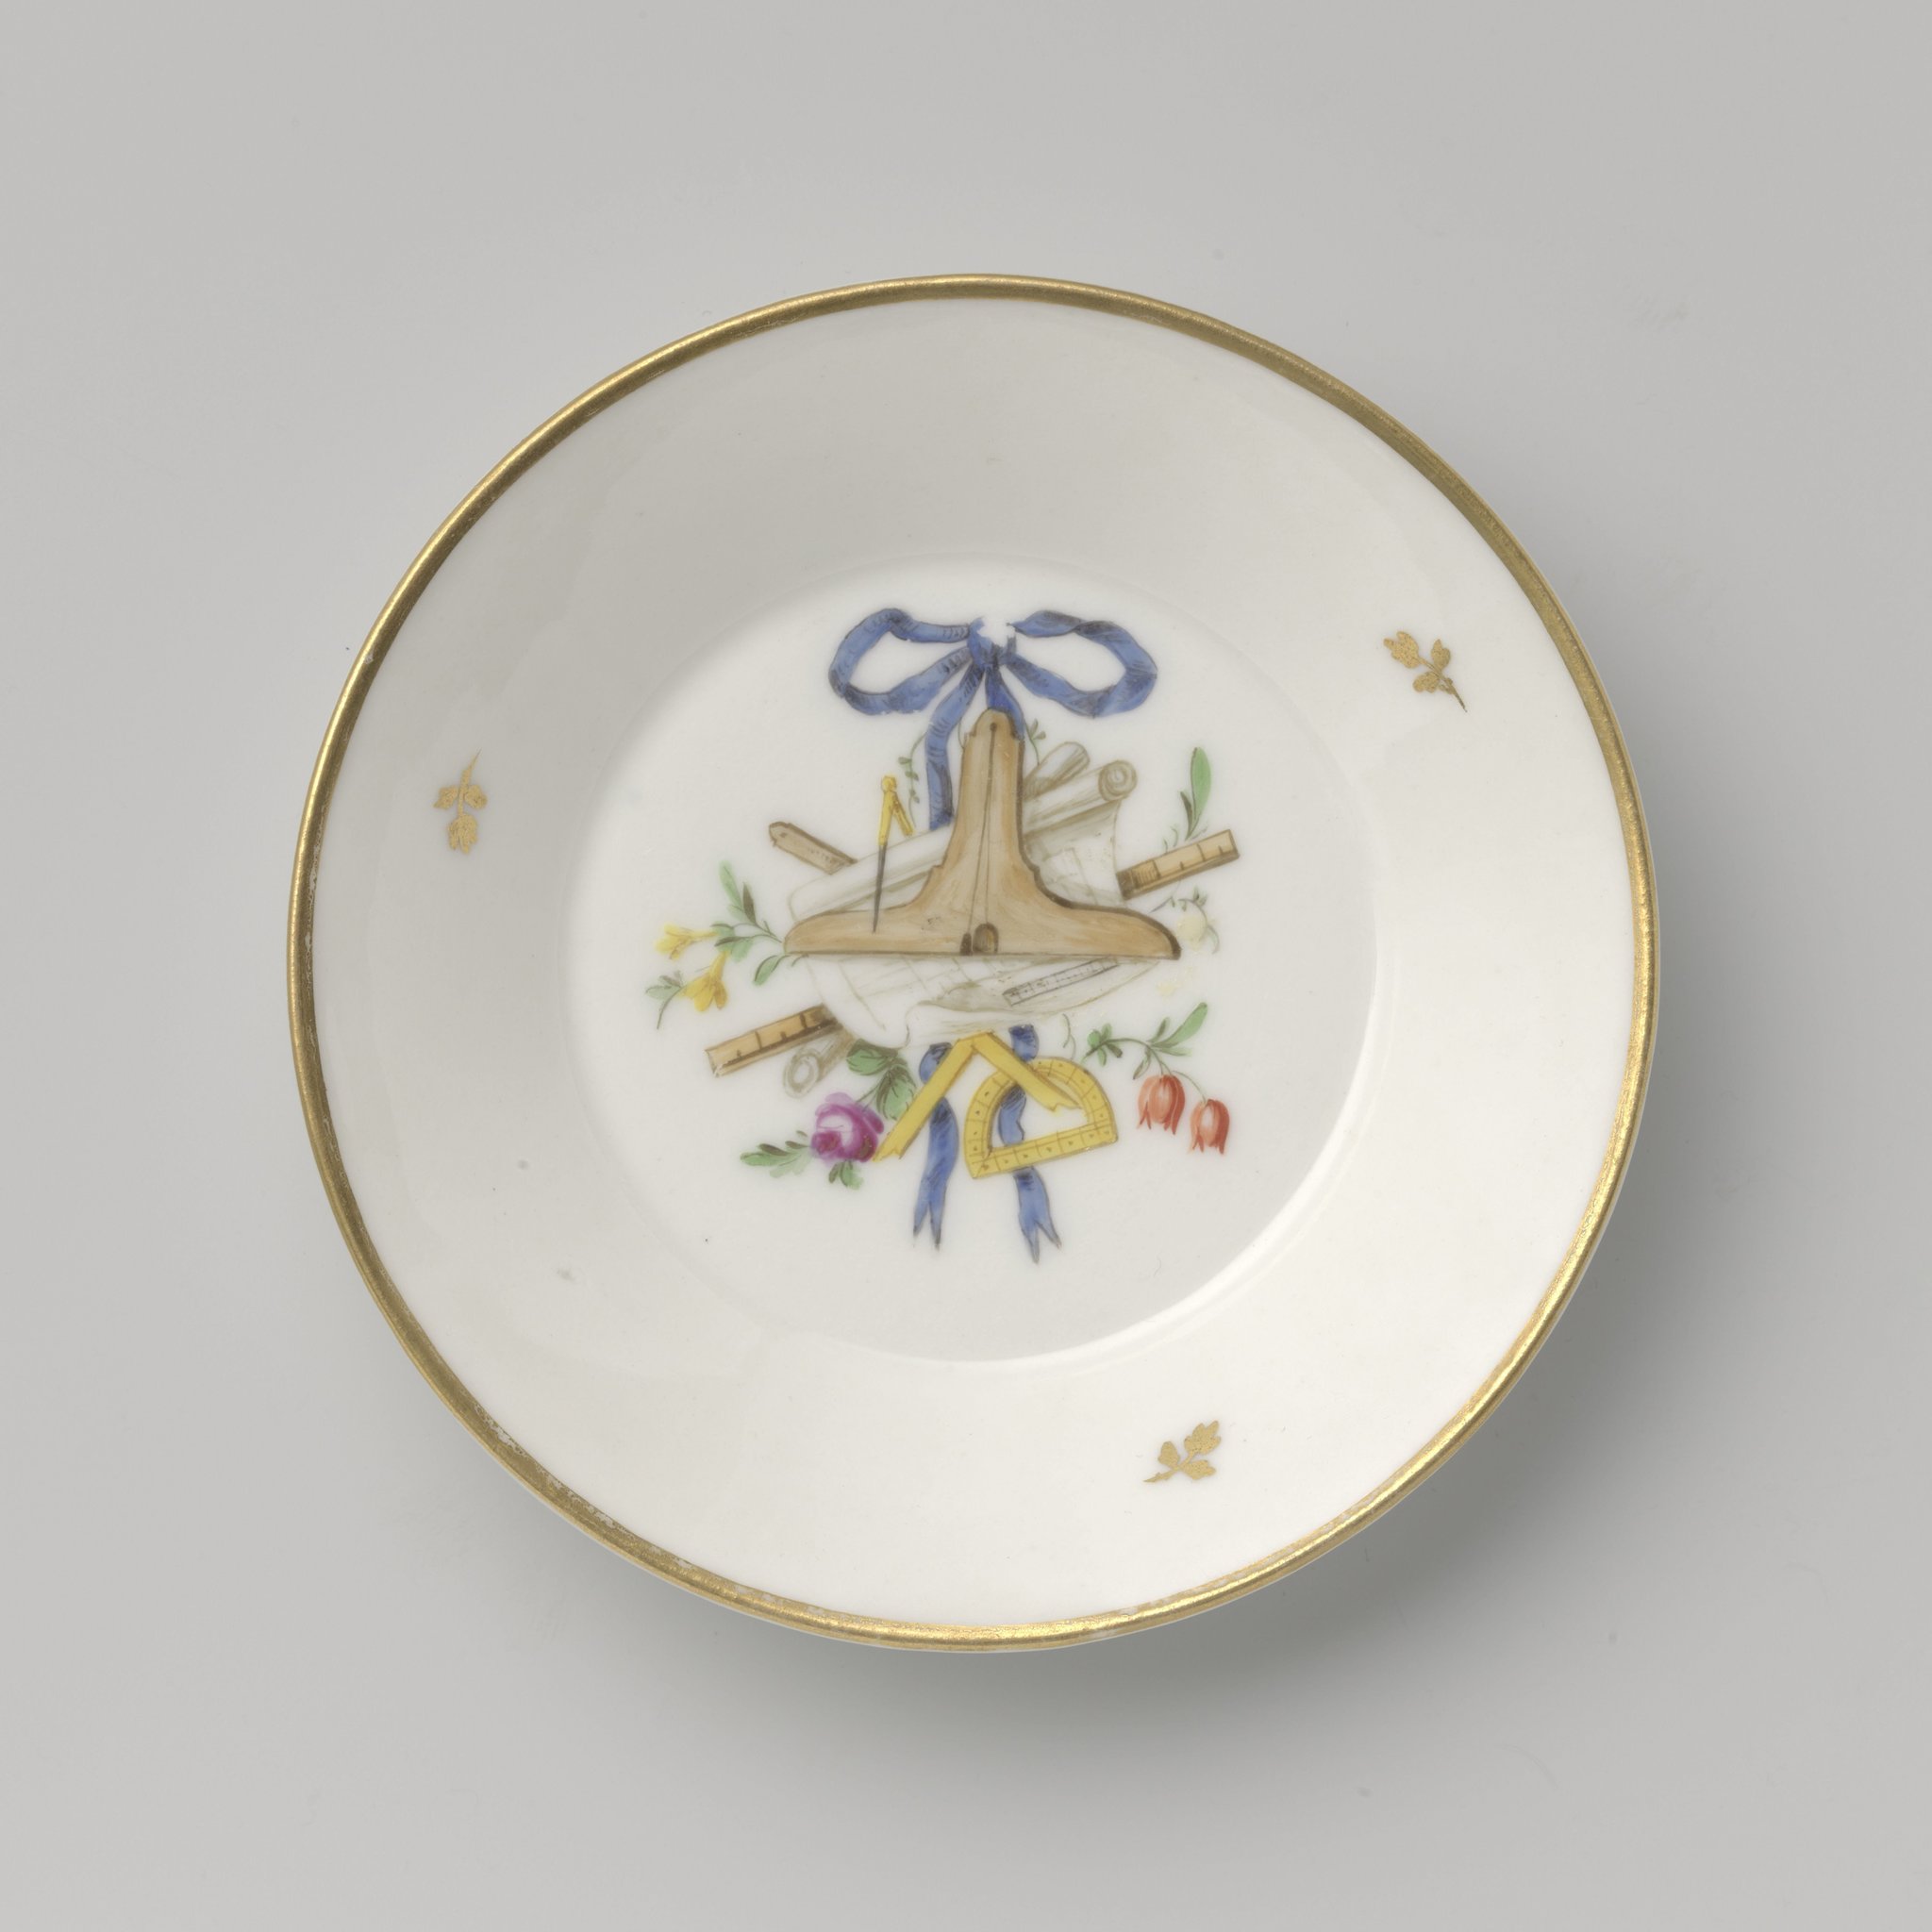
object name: platter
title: Schotel behorend bij een theeservies met decoratie van trofeeën aan gestrikte linten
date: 1809-1814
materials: porcelain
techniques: painted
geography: nieuwer-amstel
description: Theeservies bestaande uit een theepot, een suikerpot, een spoelkom en twaalf koppen en schotels veelkleurig beschilderd met trofeeën hangend aan blauwe strikken. De trofeeën hebben betrekking op diverse beroepen. Gemerkt in zwart: Amstel (de suikerpot Amstel N. 805 en ingegrift A). Verschillende ingegrifte merken in de koppen en schotels.